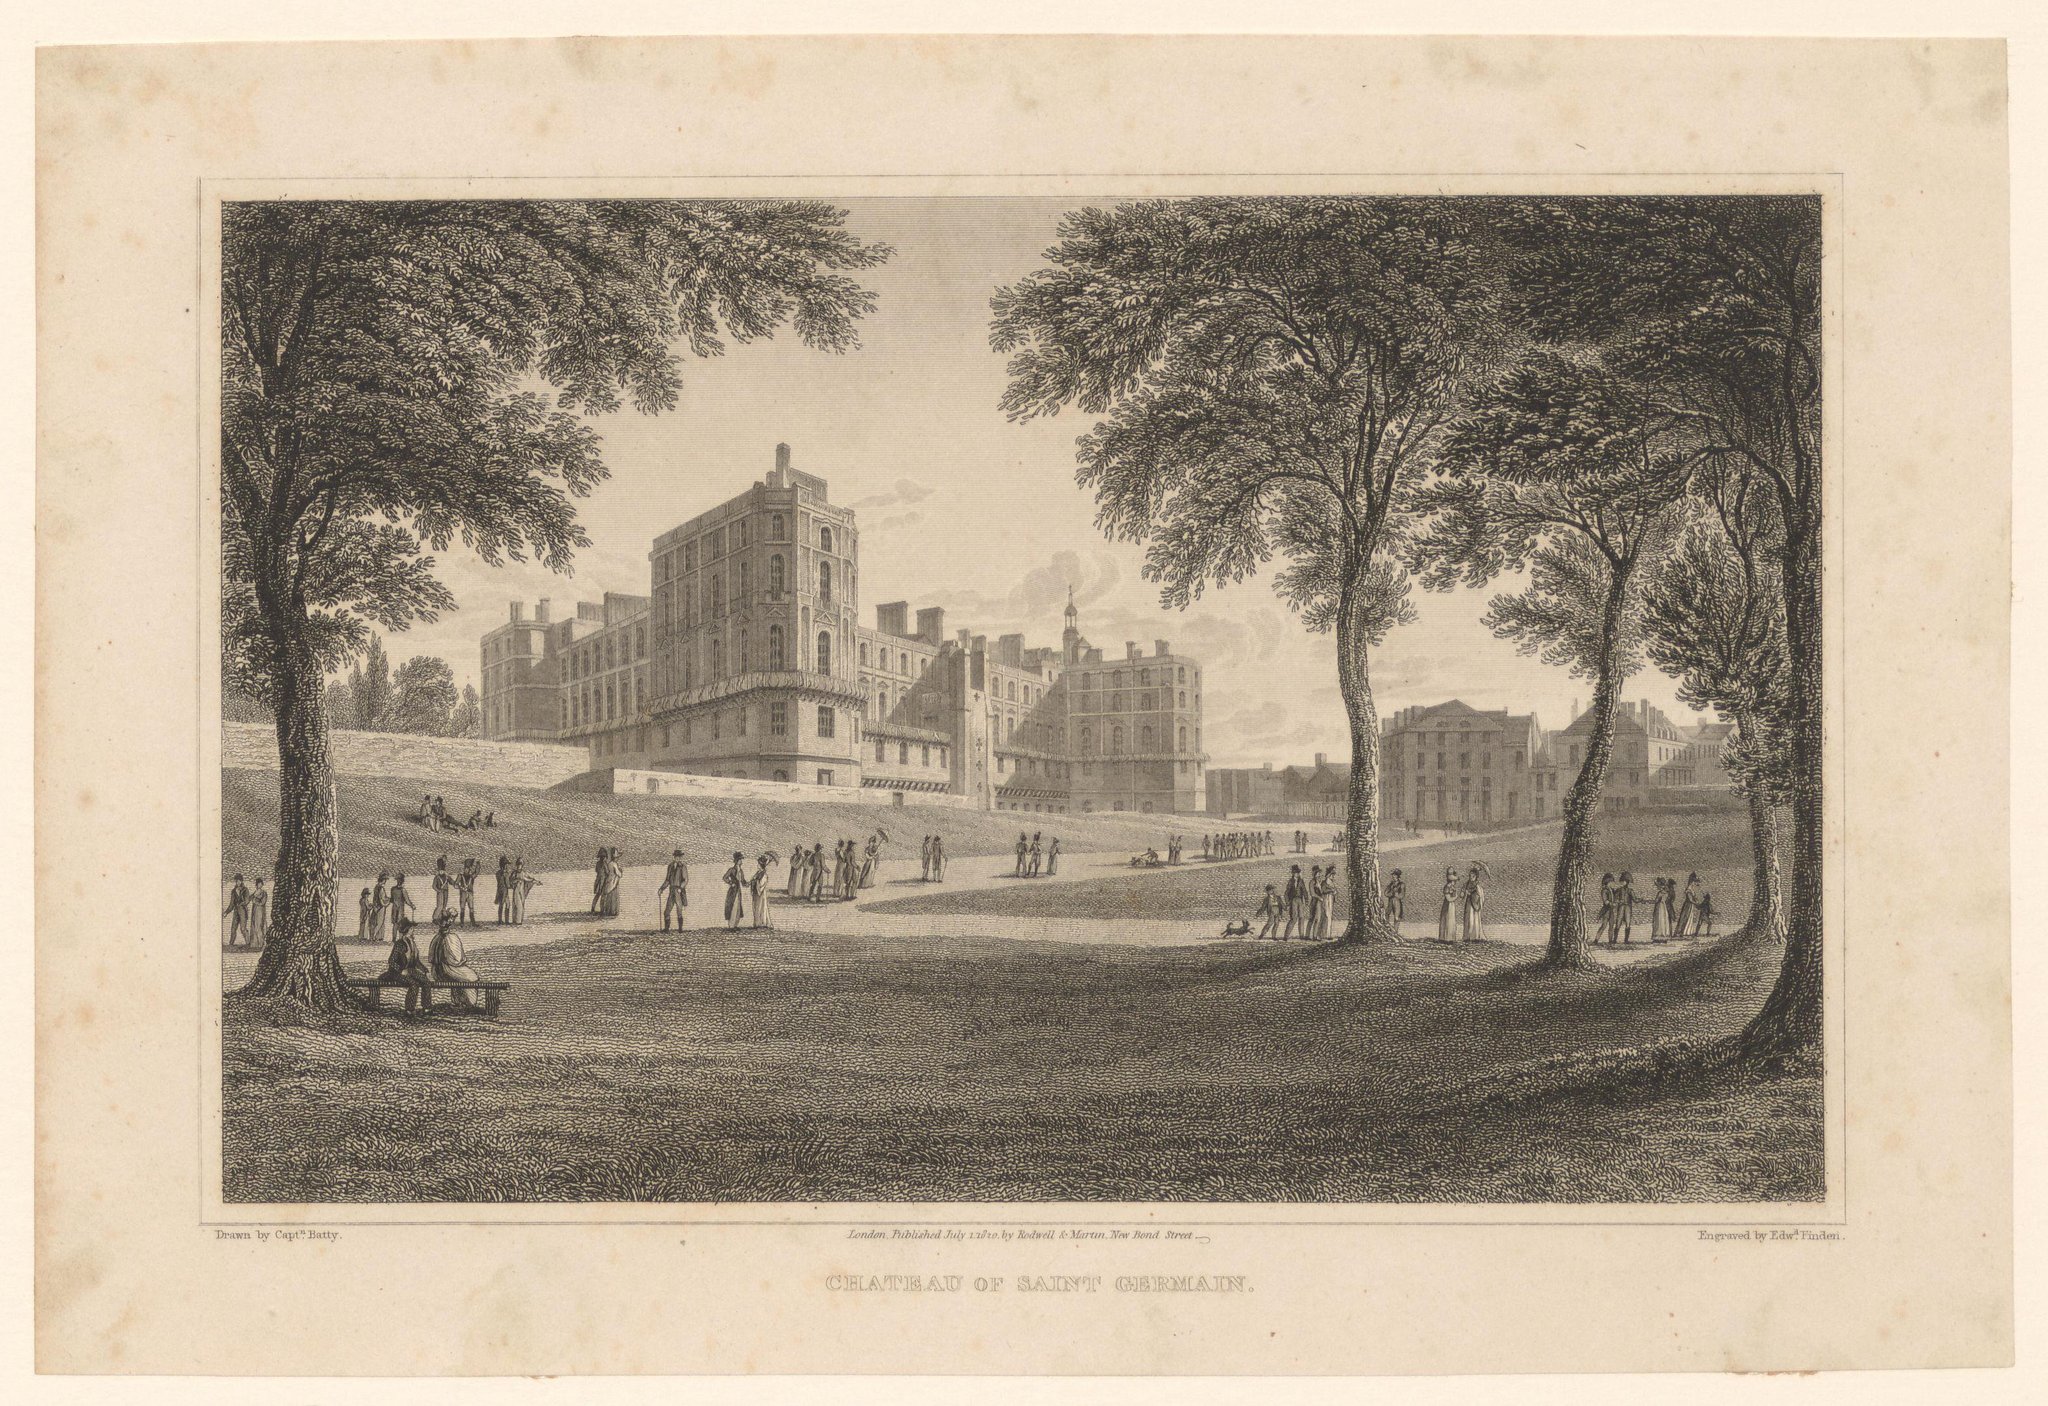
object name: print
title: Gezicht op het Kasteel van Saint-Germain-en-Laye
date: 1807-1820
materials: paper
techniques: etching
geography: london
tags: castle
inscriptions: collector's mark: Lugt 2228